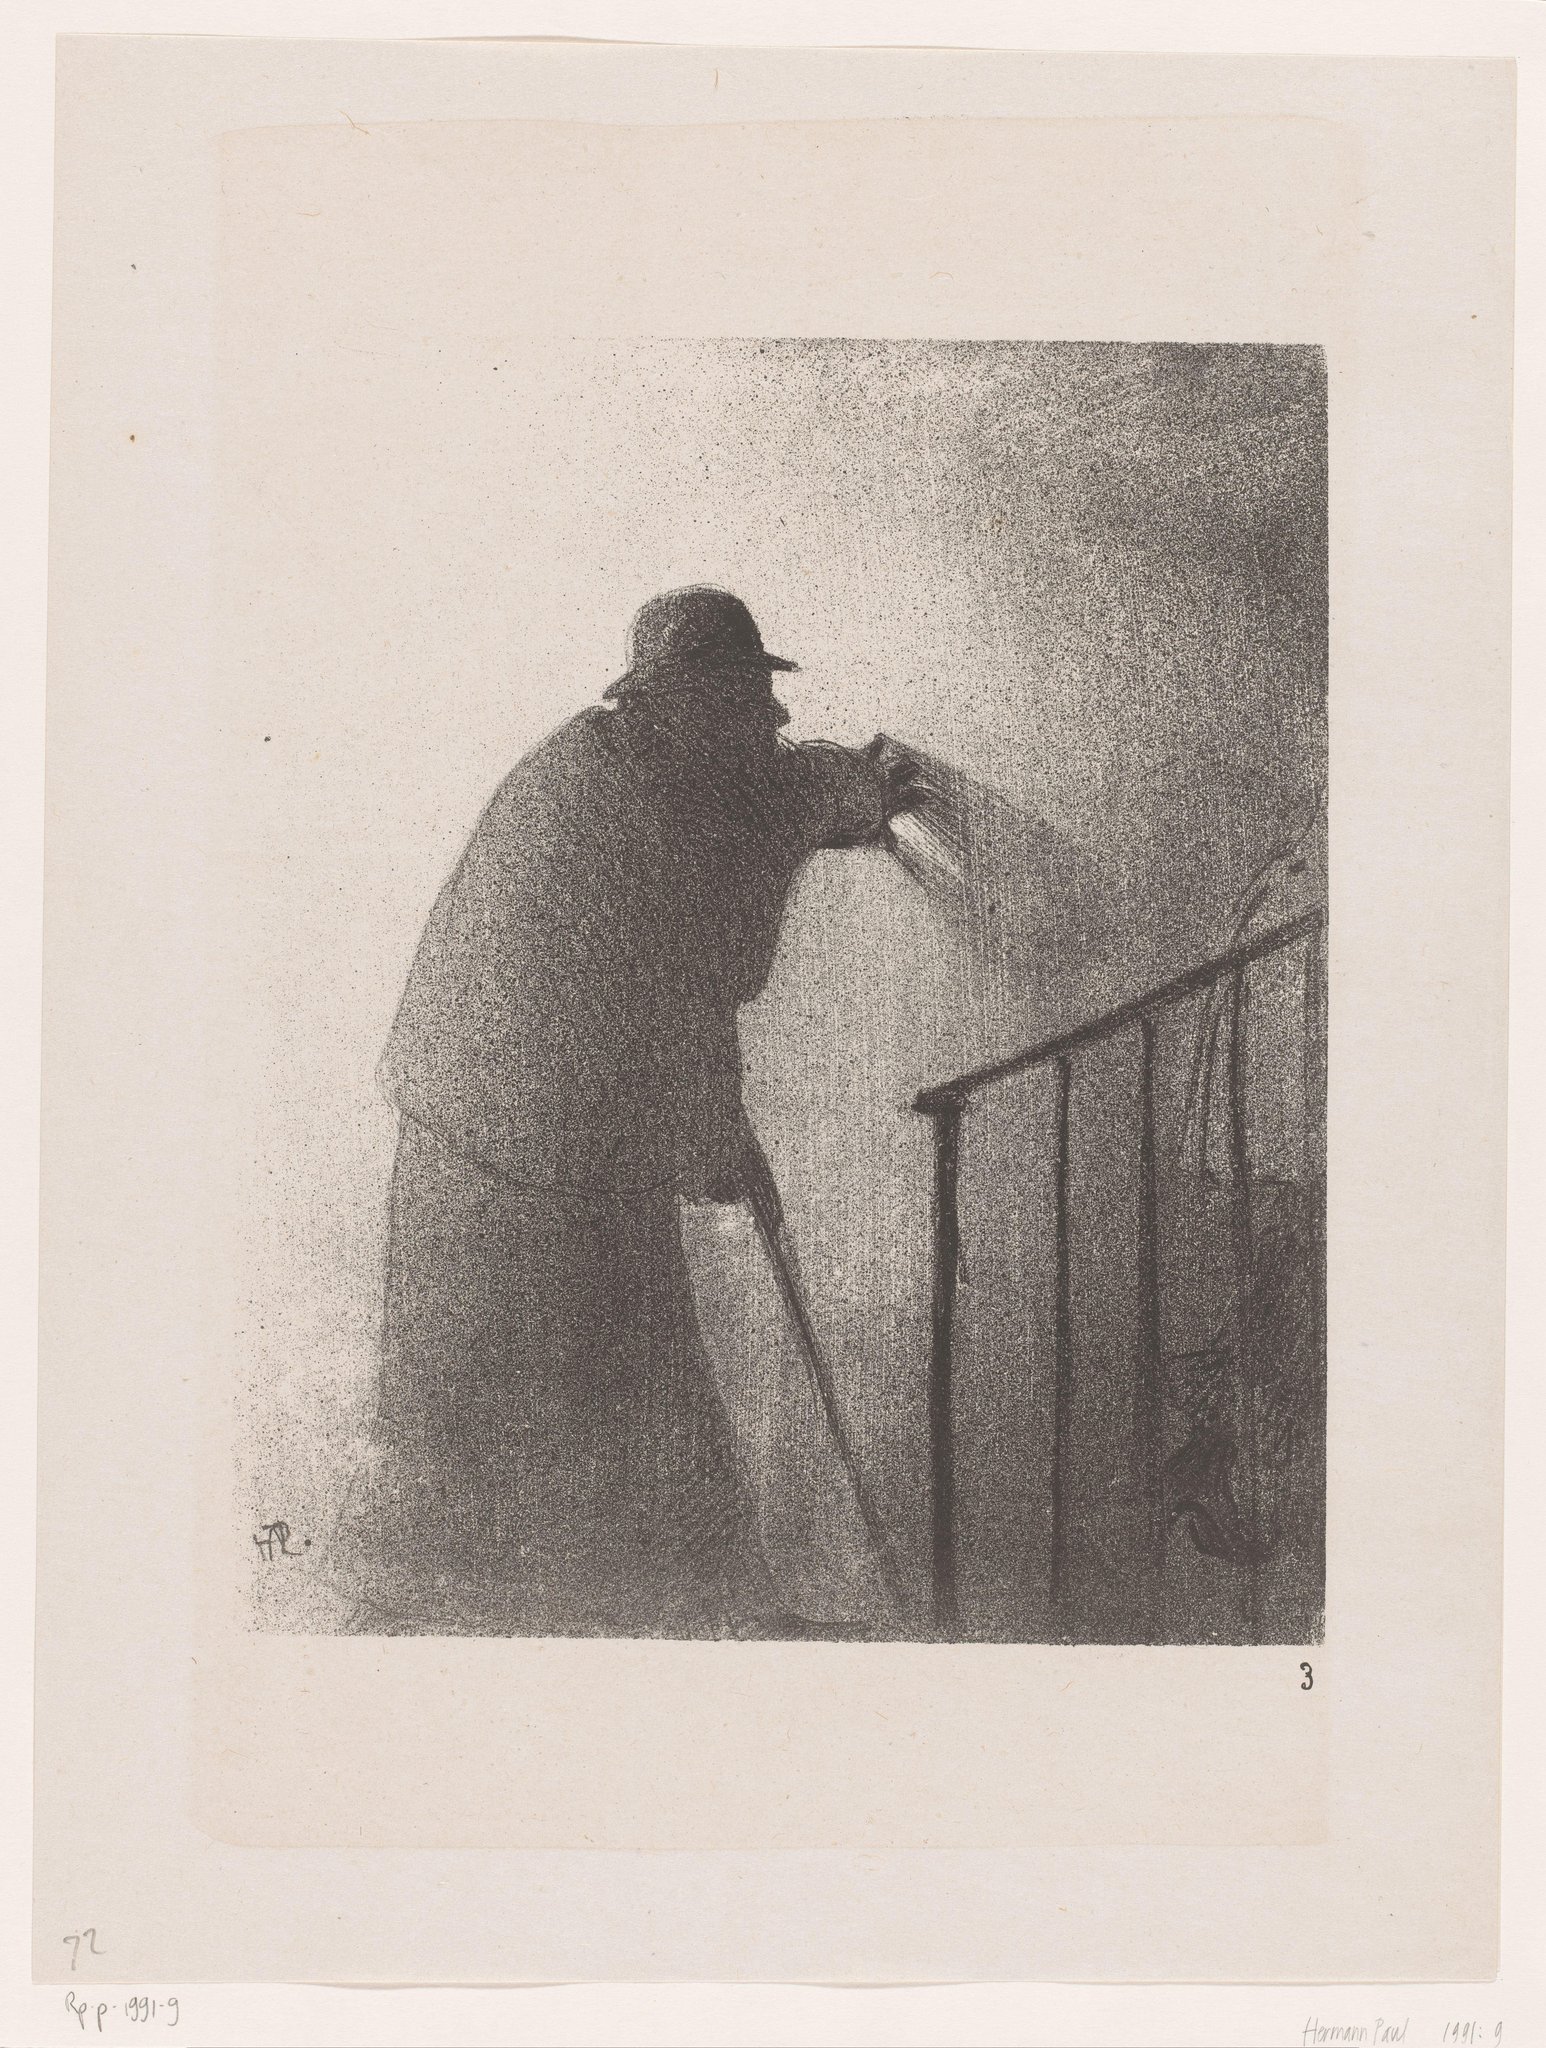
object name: print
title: Il aime pour la première fois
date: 1895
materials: paper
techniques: lithograph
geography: paris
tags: staircase, couple of lovers